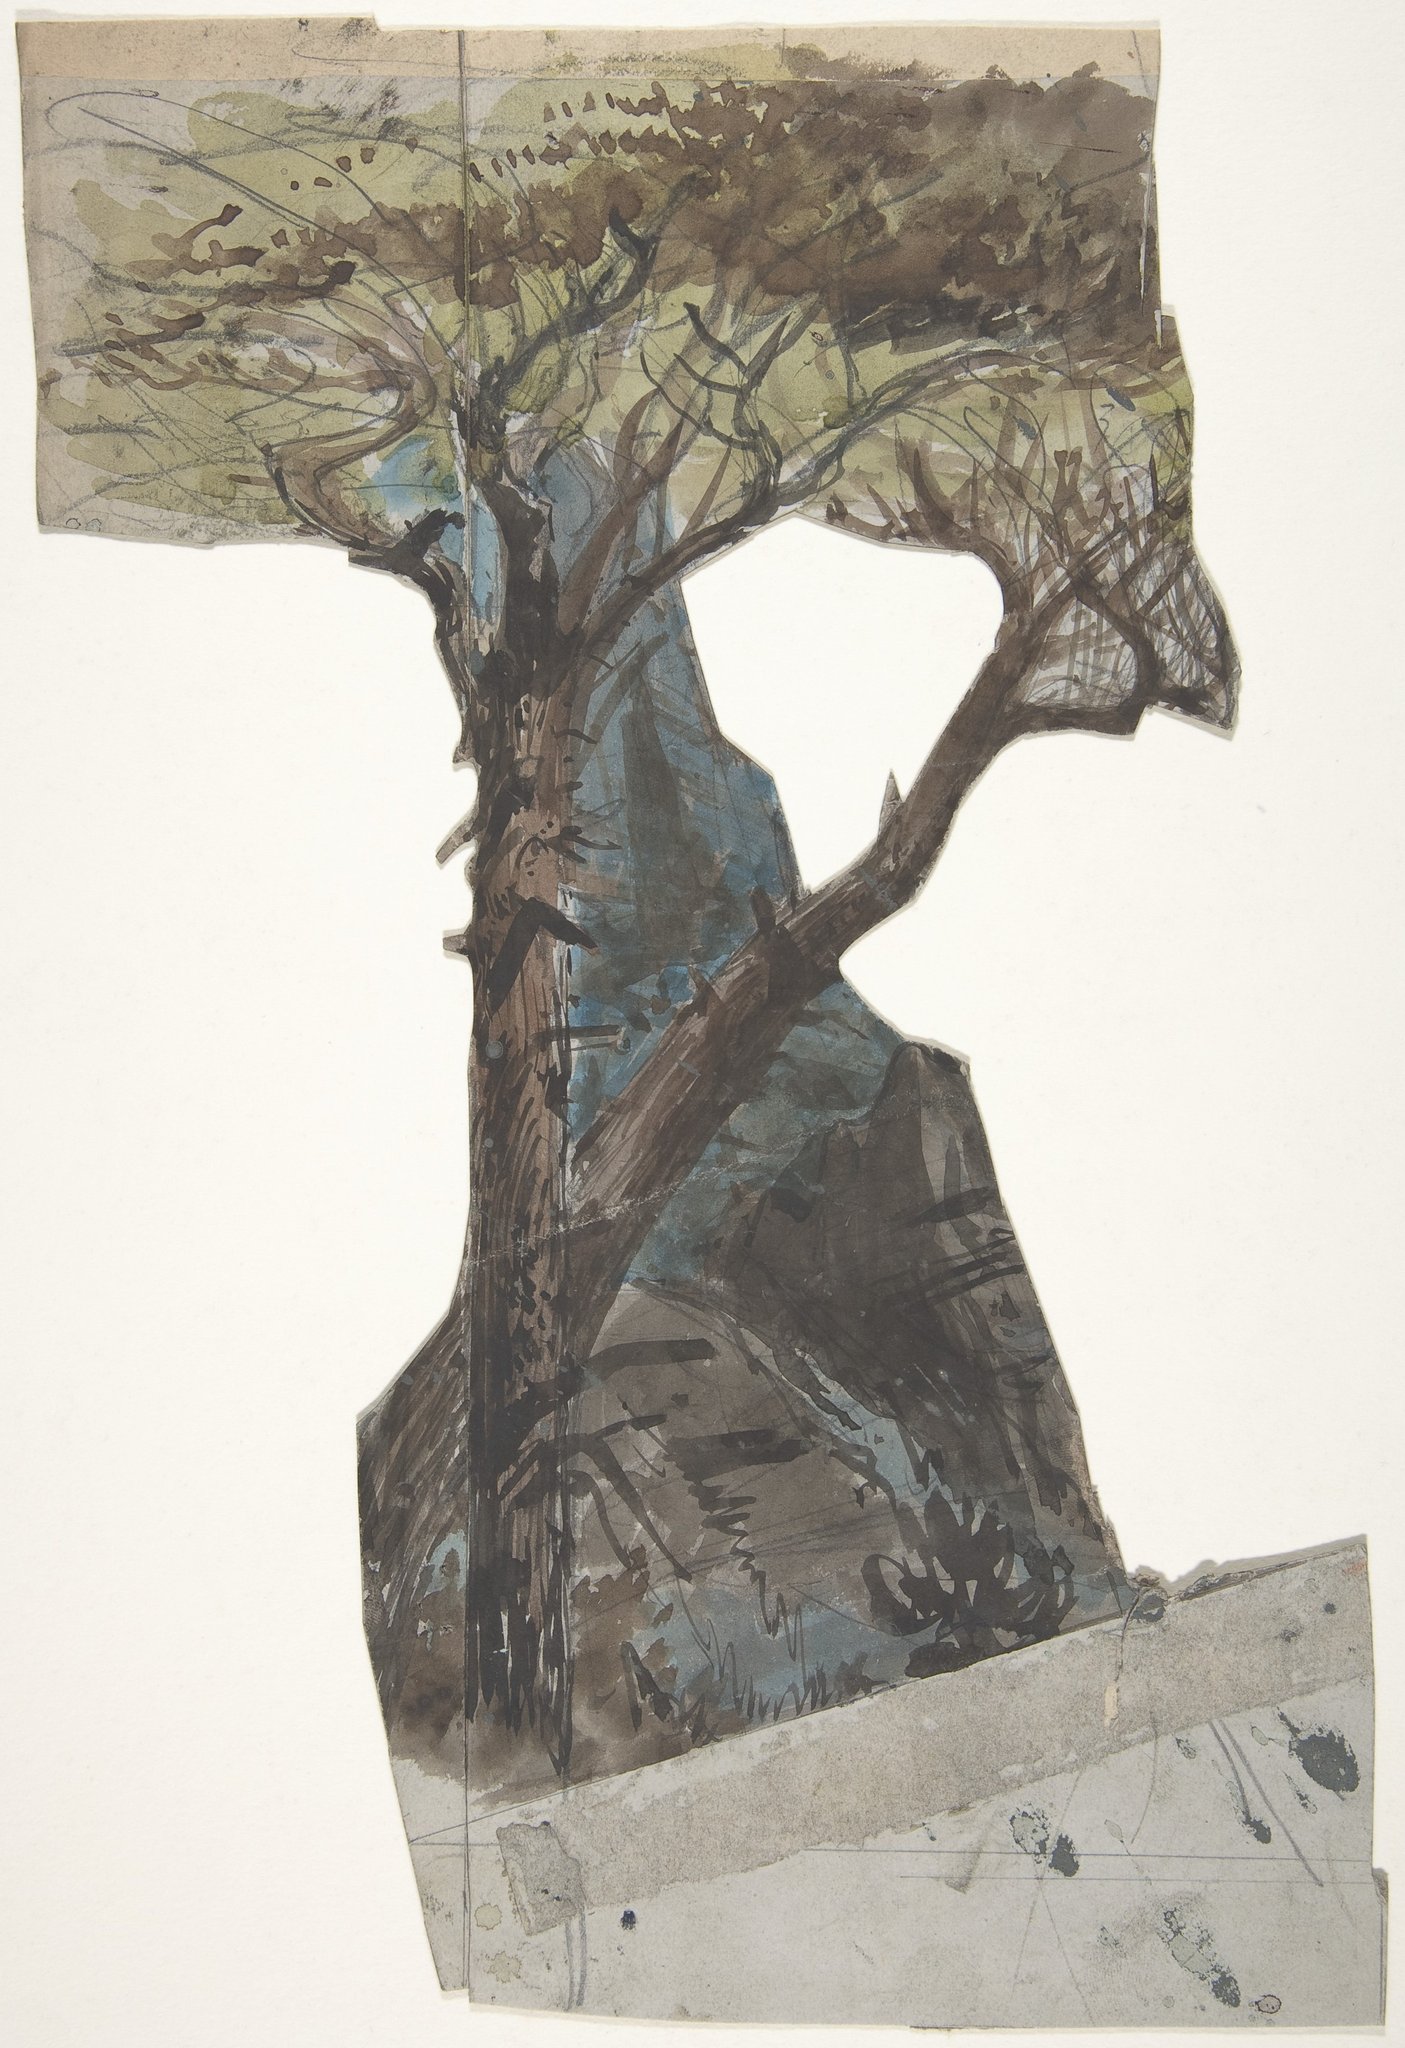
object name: drawing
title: Design for a Stage Set at the Opéra, Paris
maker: eugène cicéri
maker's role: artist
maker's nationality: french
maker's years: 1813-1890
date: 1830-1890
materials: graphite, watercolor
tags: trees,stage design